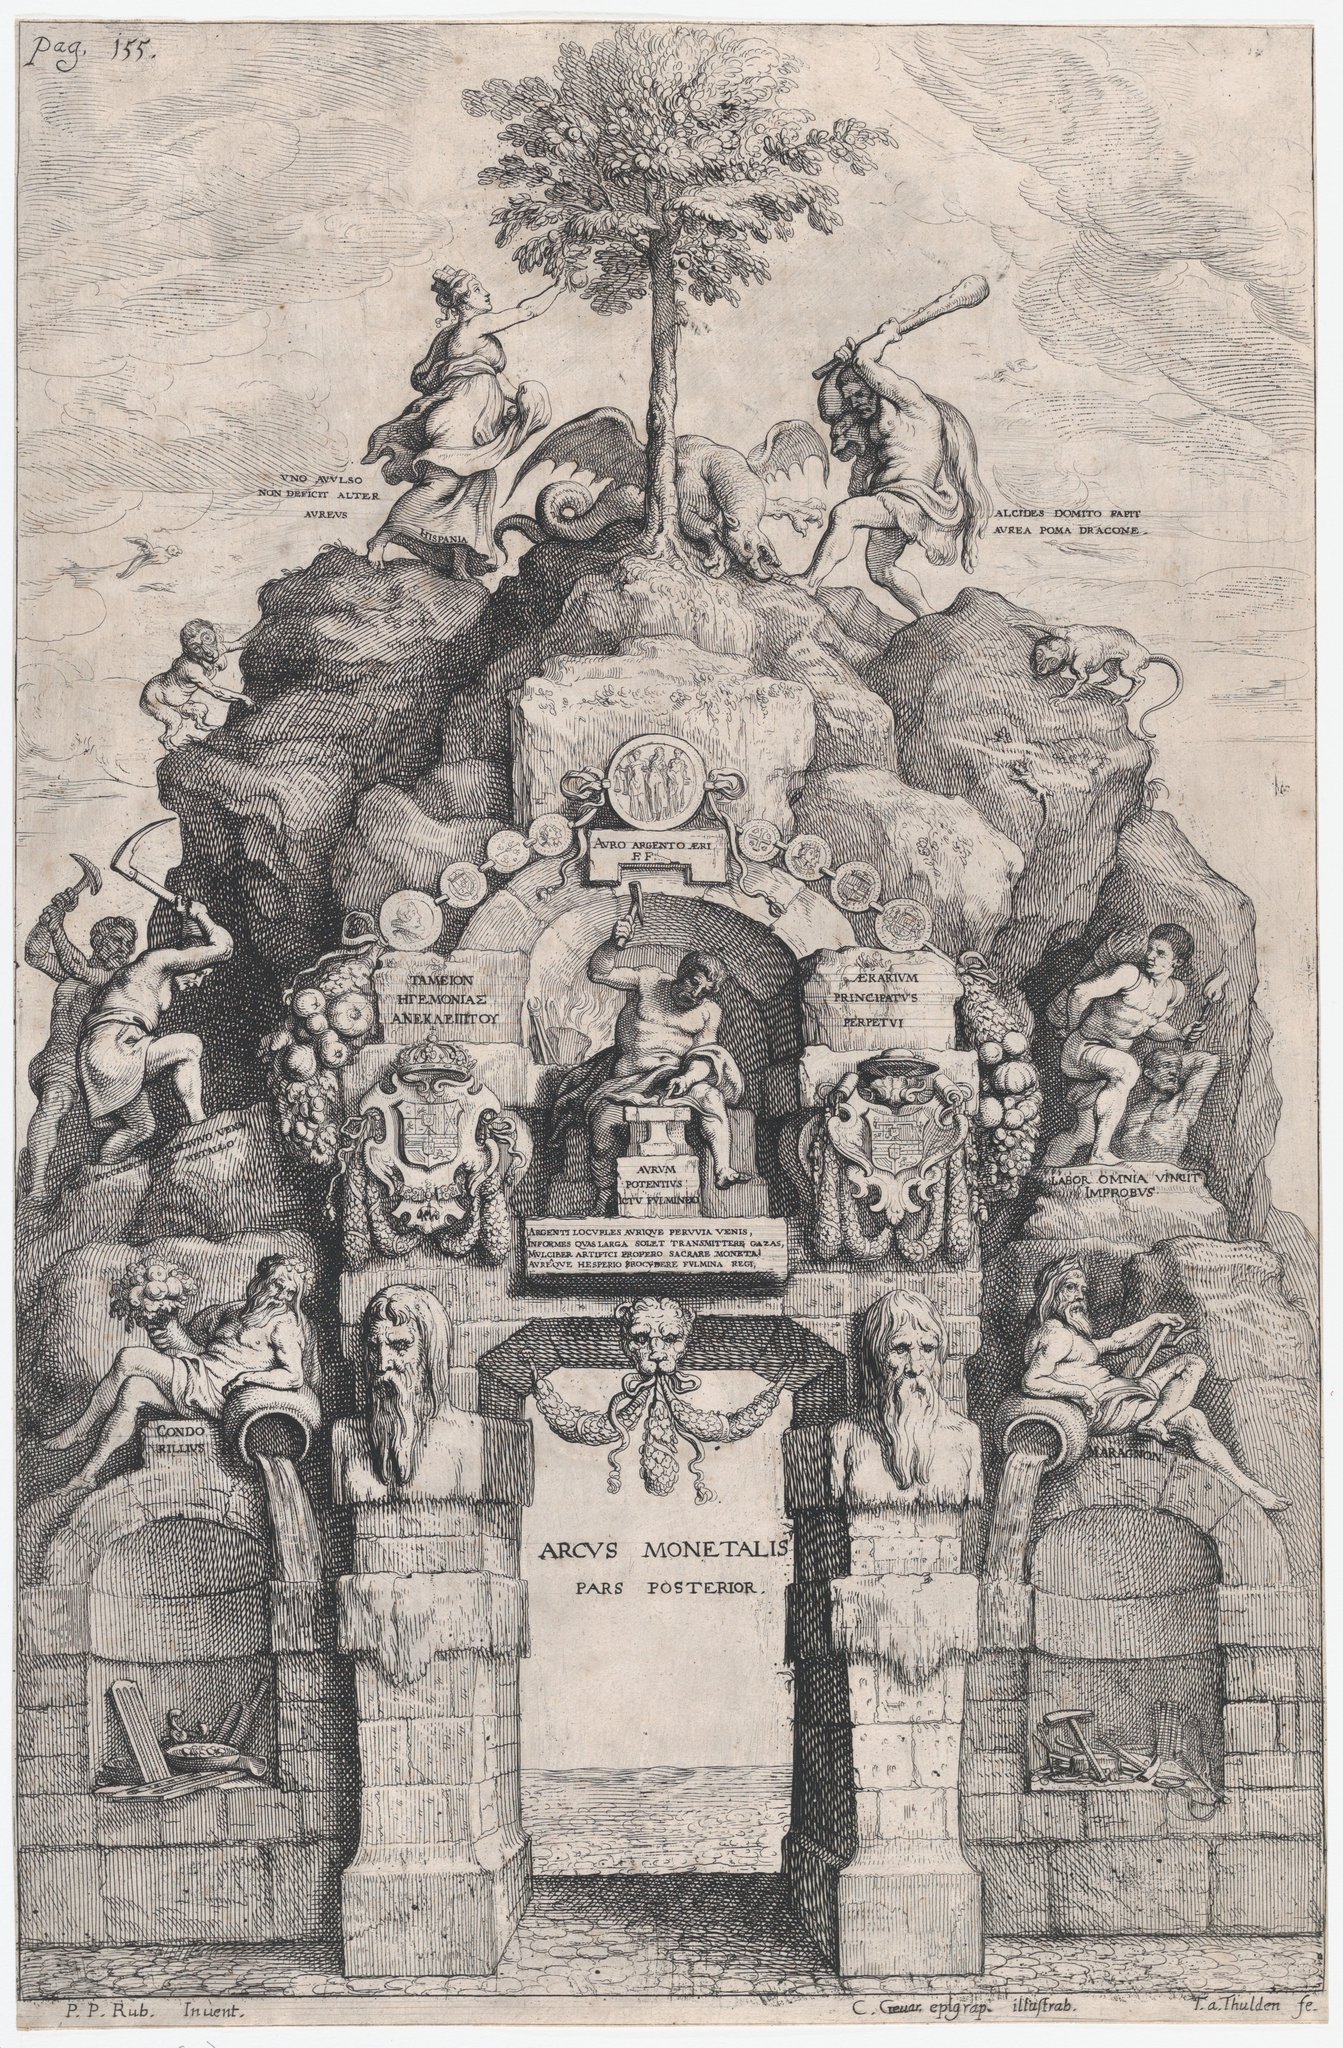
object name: print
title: Pompa Introitus...Ferdinand, Austriaci. Antwerp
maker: peter paul rubens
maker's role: artist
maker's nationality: flemish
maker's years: 1577-1640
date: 1635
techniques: etching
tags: men,women,dragons,trees,coat of arms